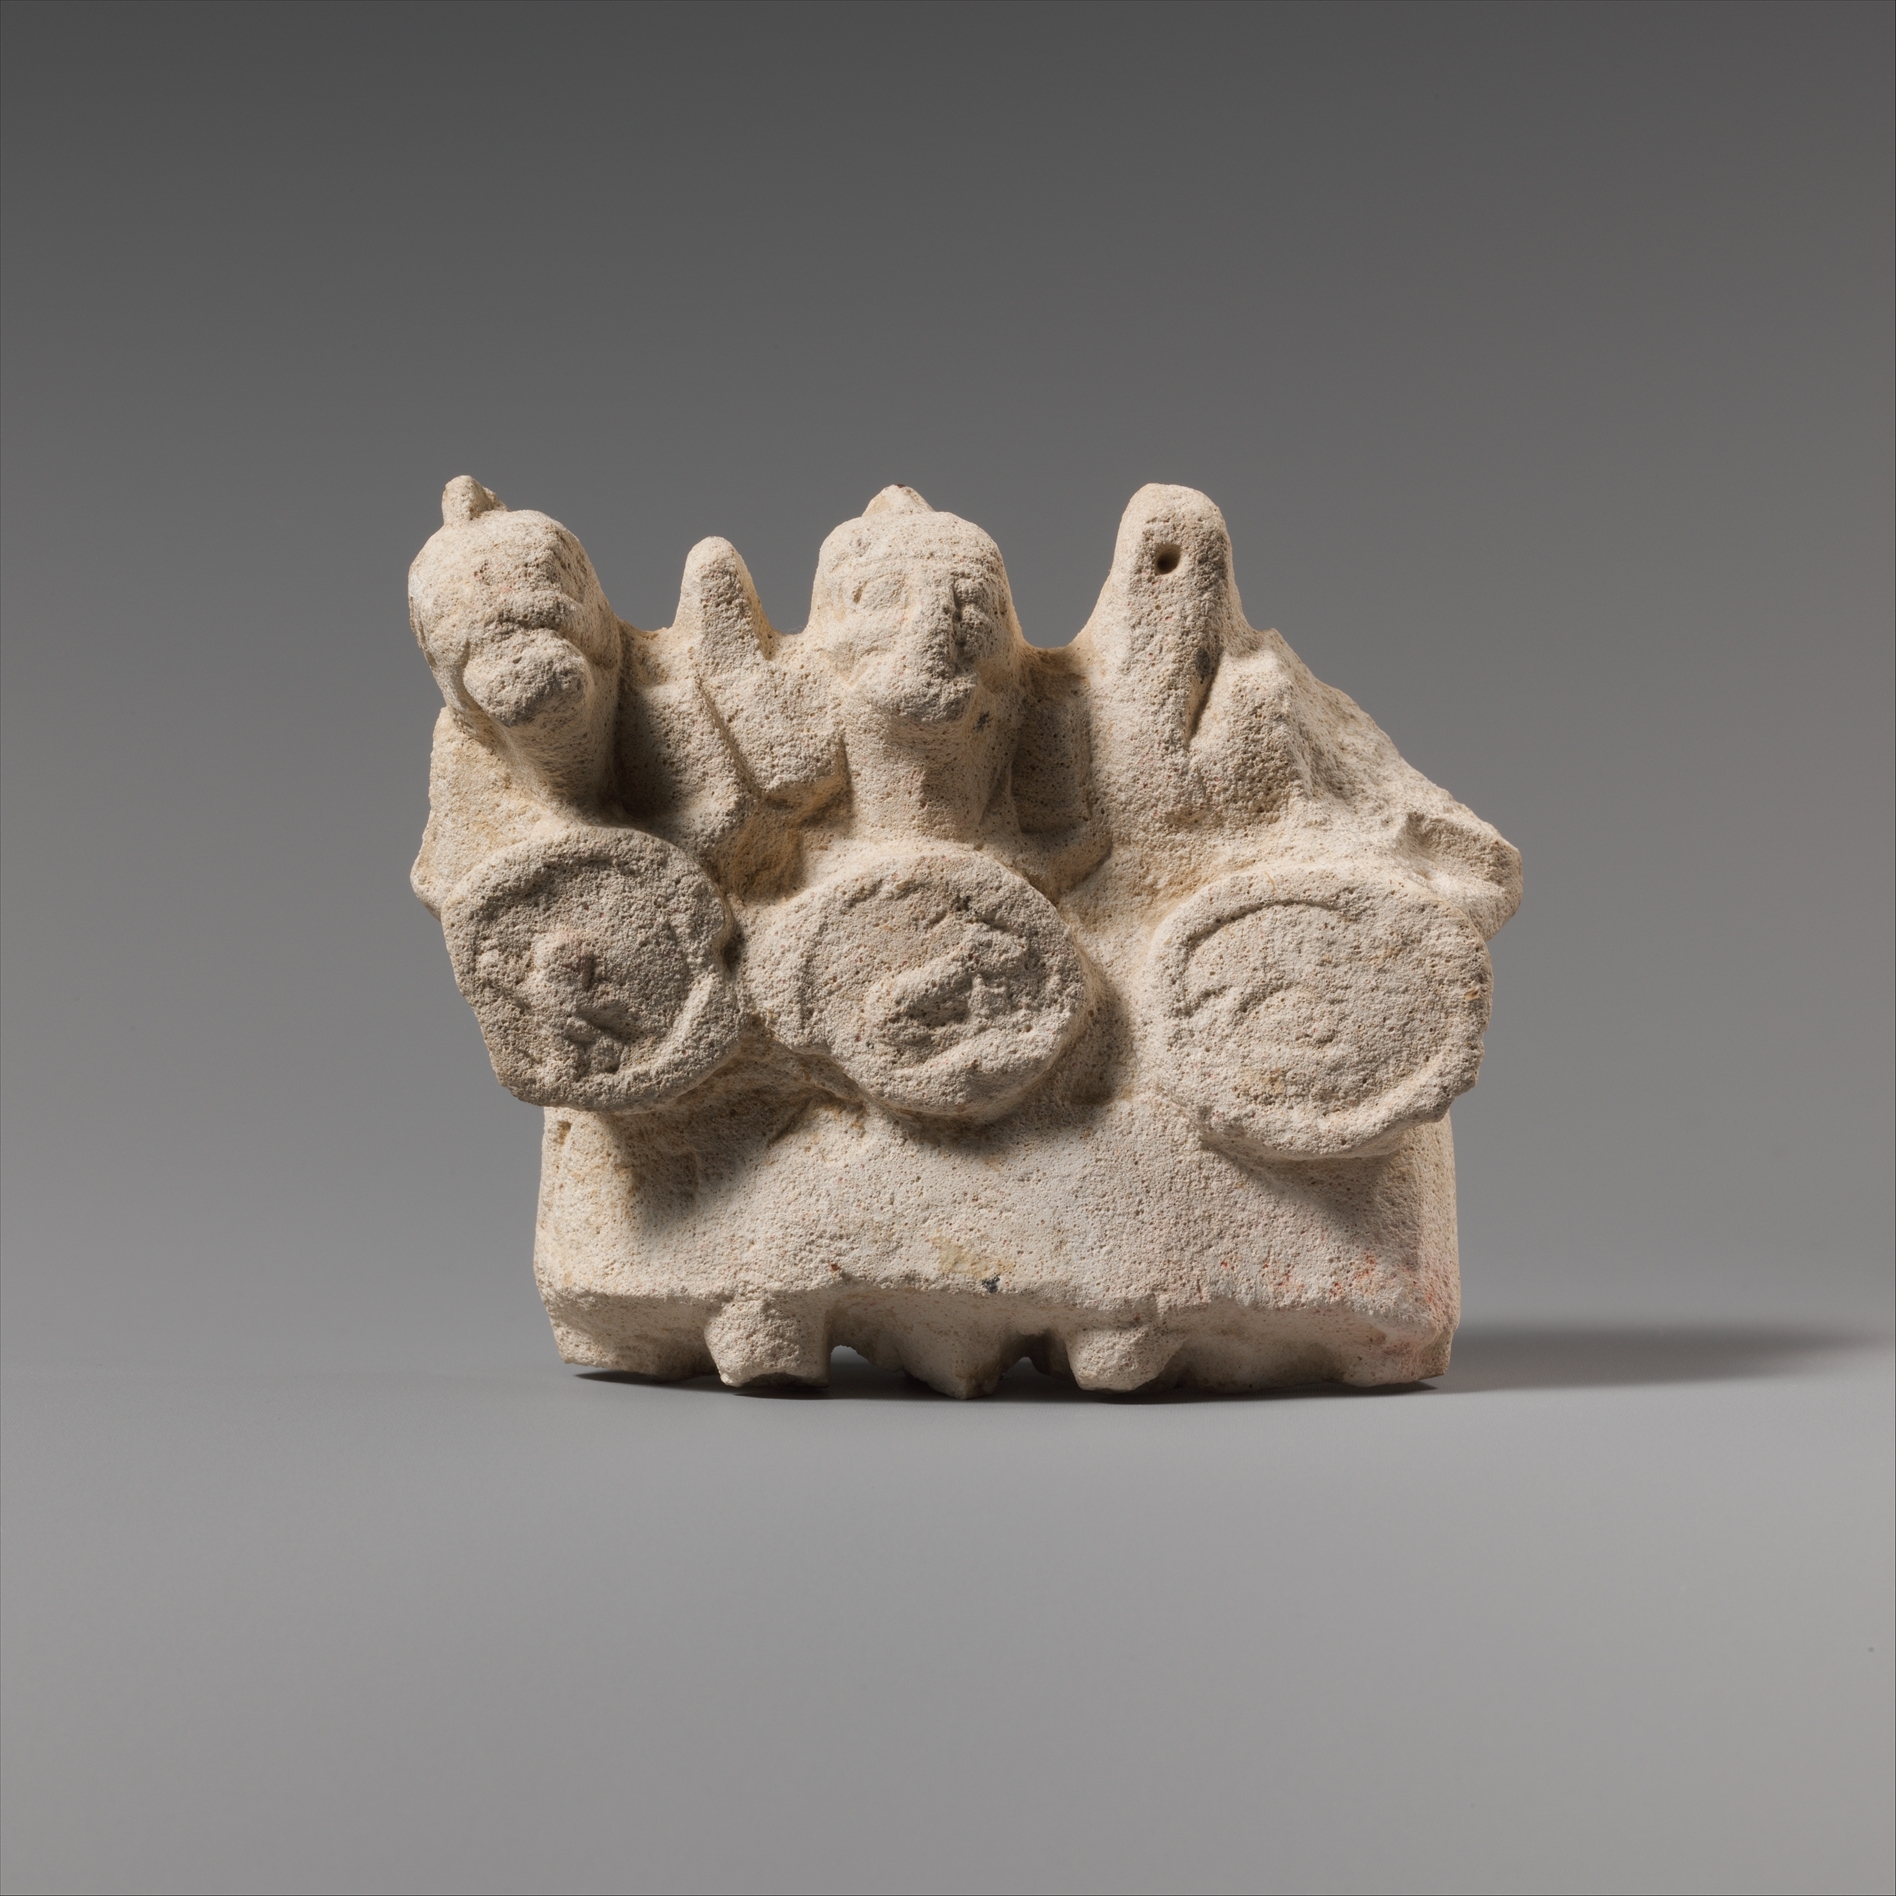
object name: statuette of triple geryon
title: Limestone statuette of Geryon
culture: cypriot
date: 500-468 BCE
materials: limestone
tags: shields,sphinx,lions